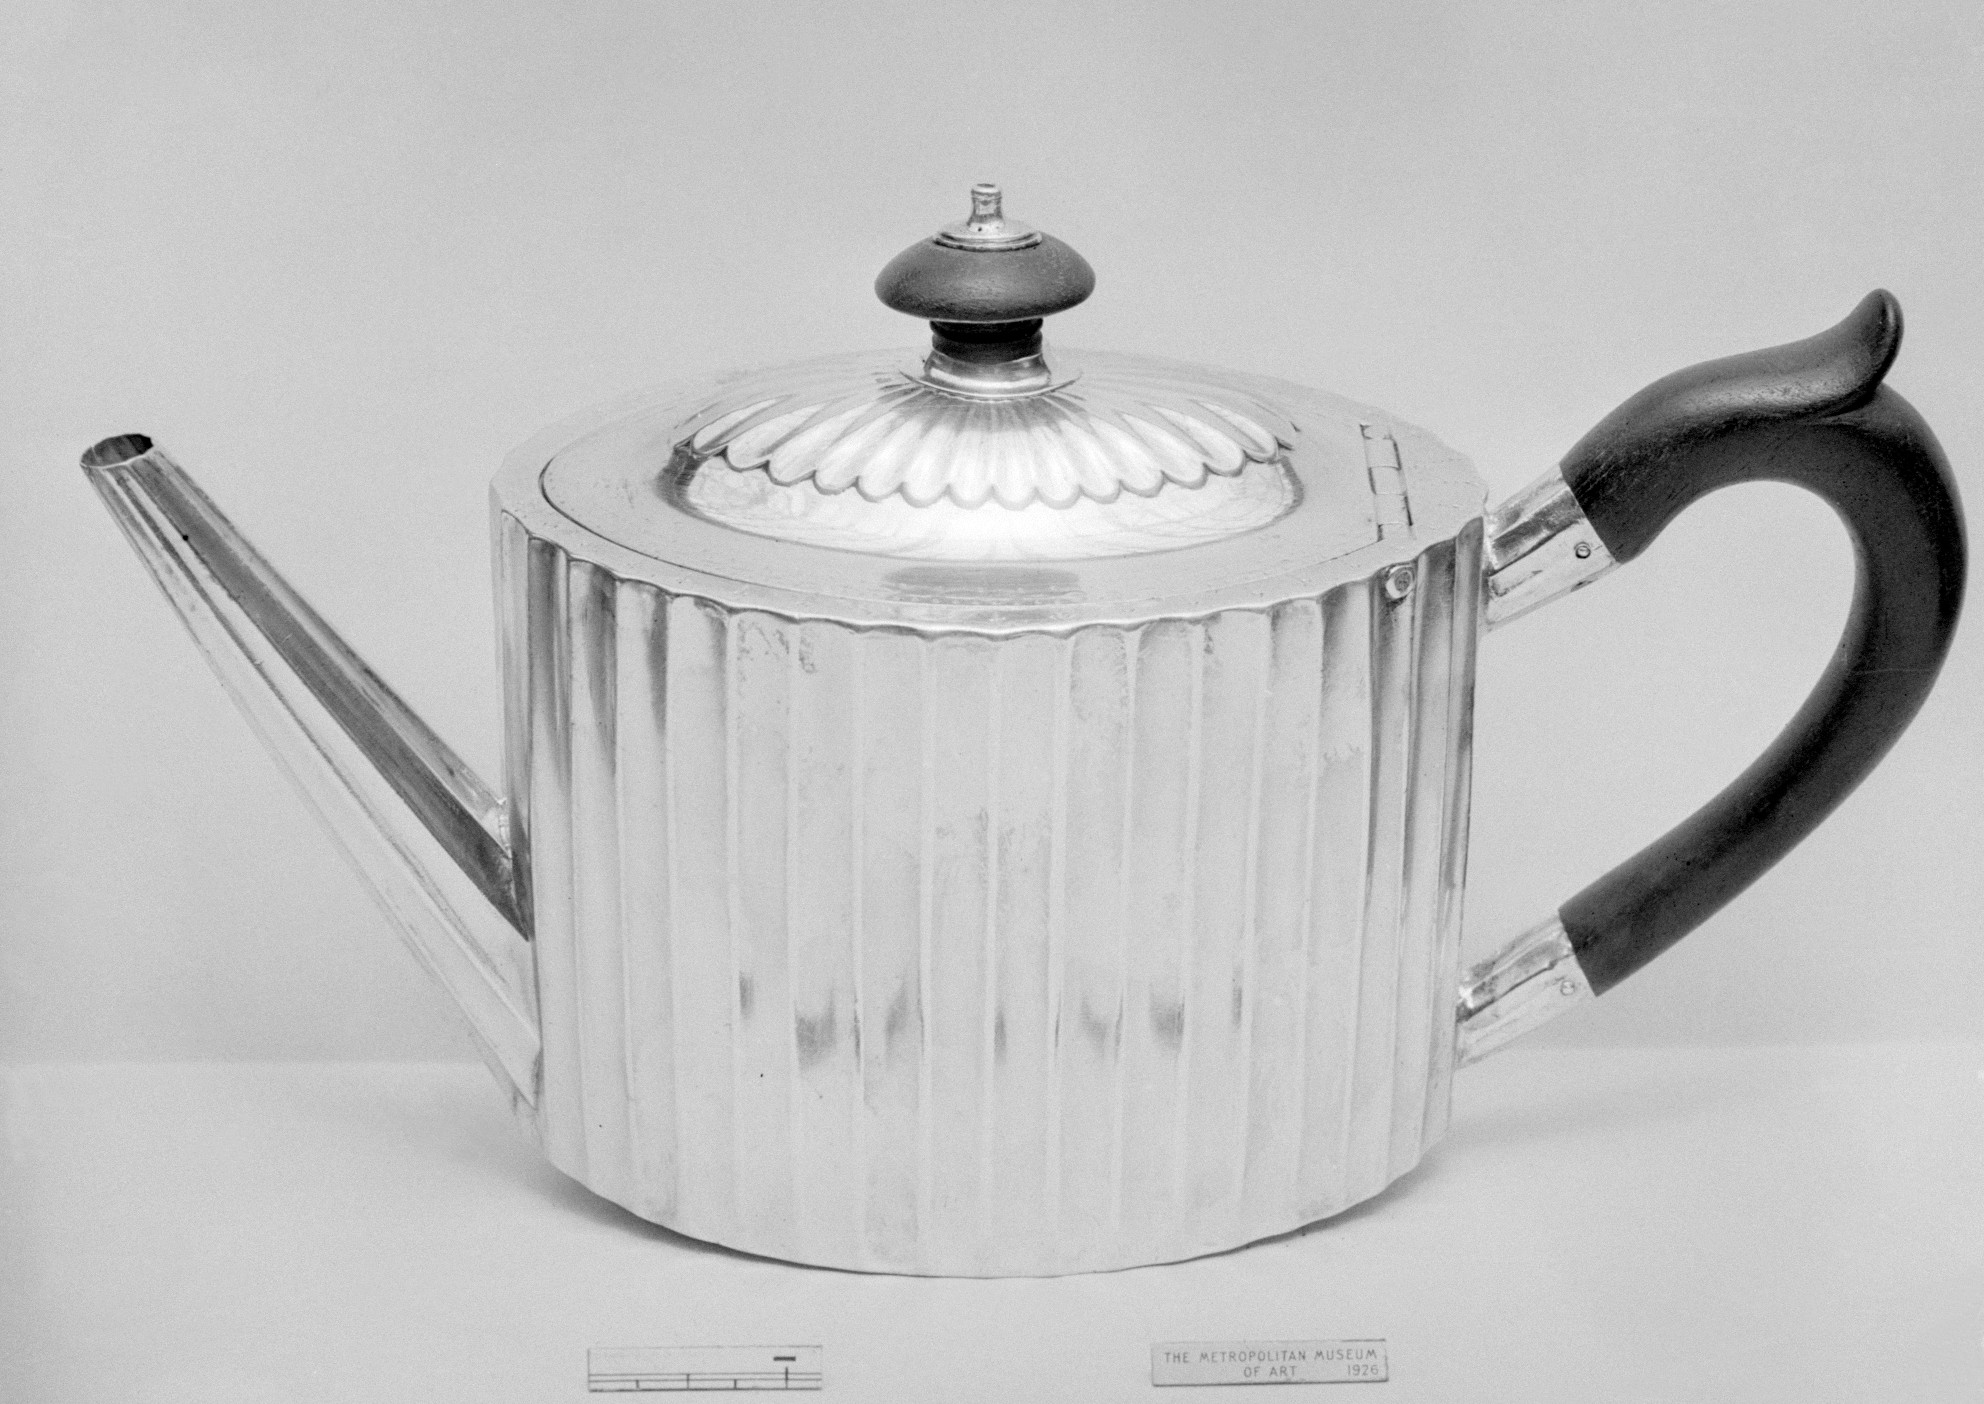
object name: teapot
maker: william plummer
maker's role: maker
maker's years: 1755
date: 1784-1785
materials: silver, wood